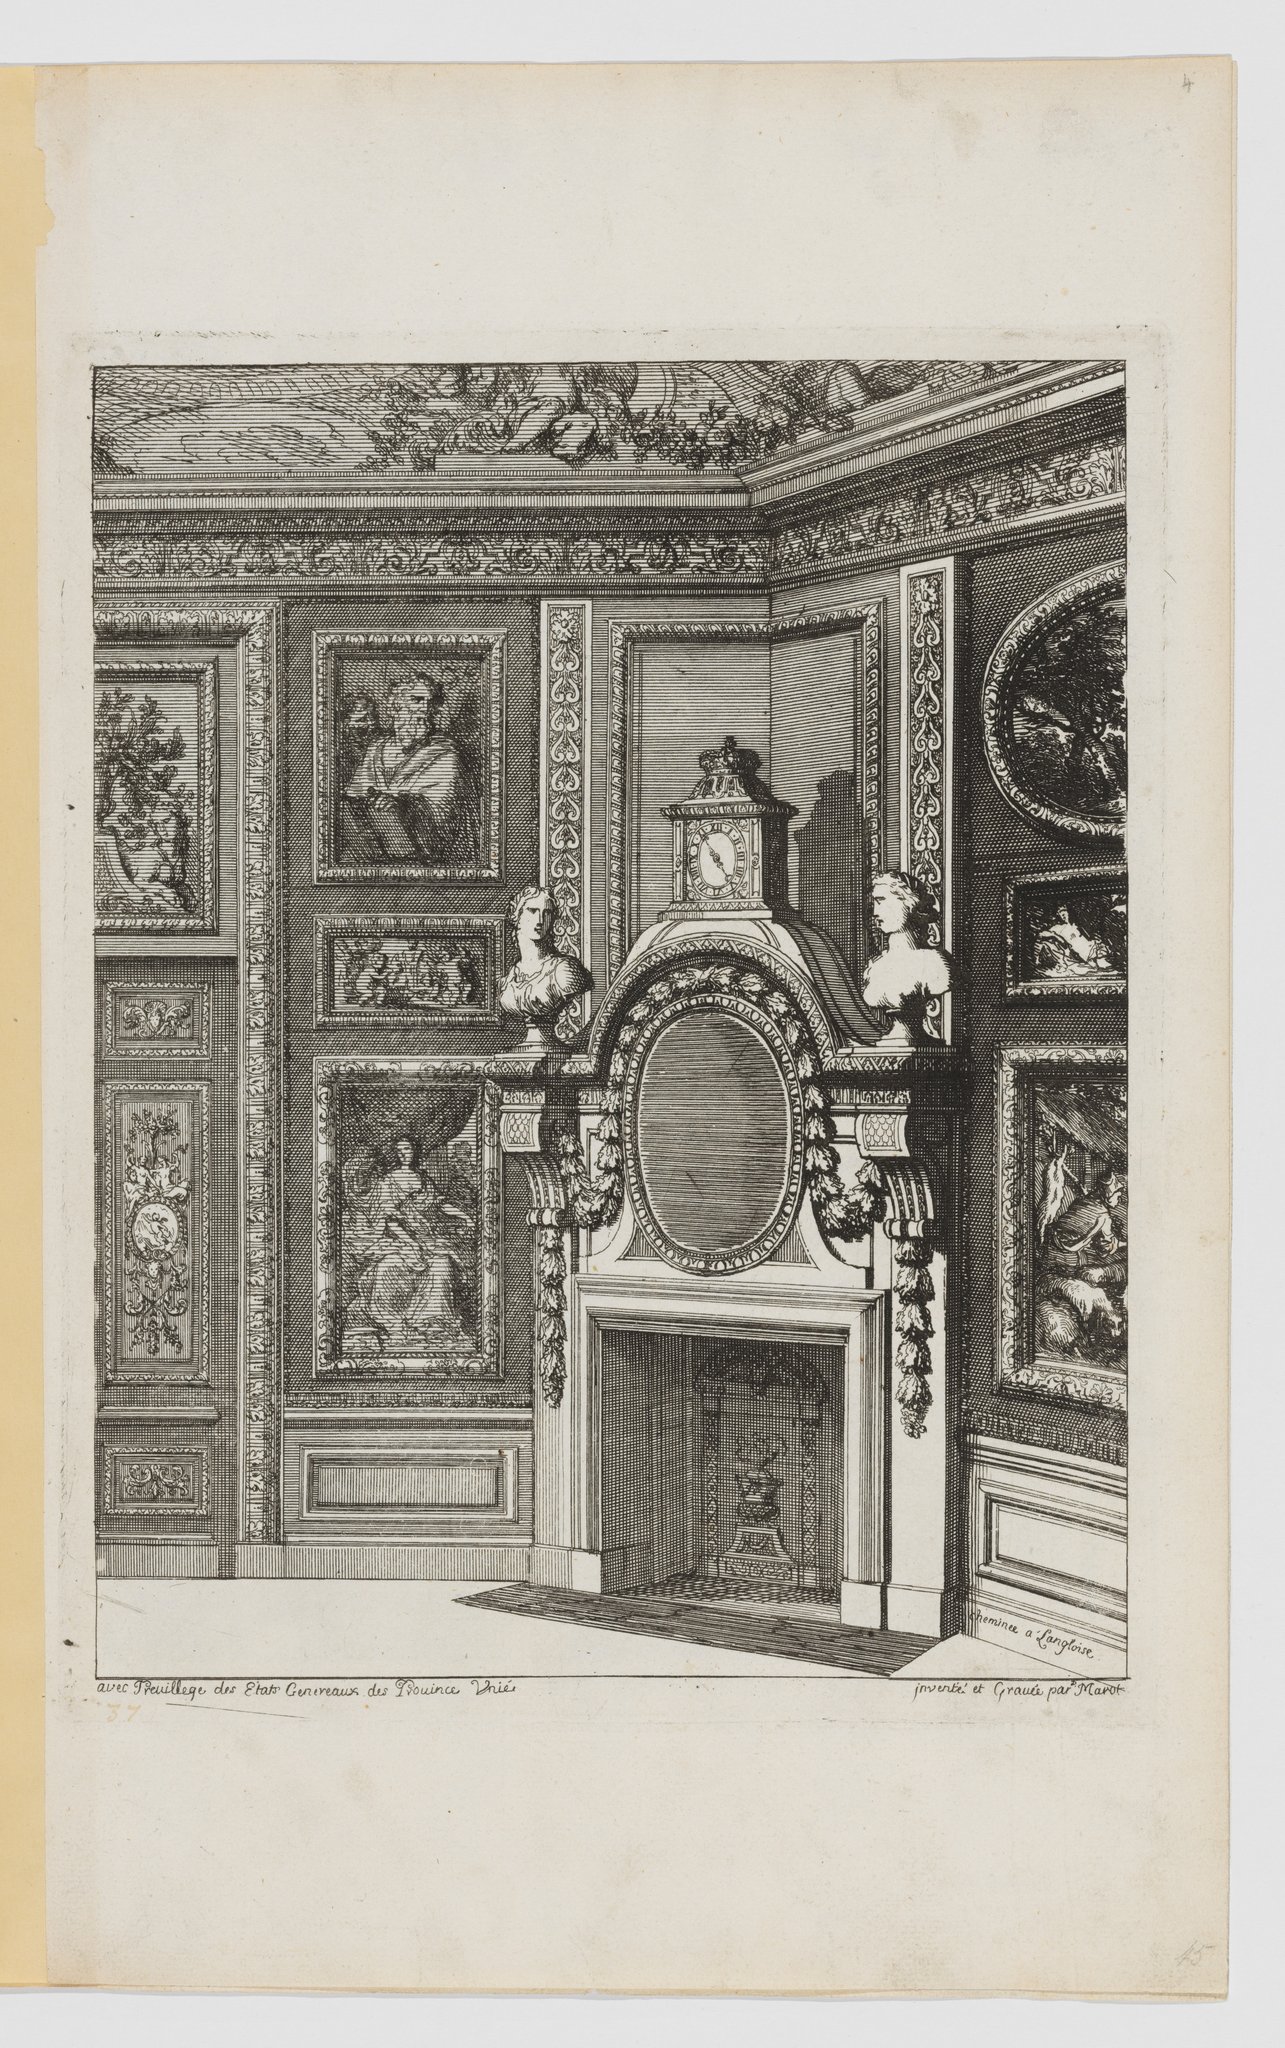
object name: print collection ornament architecture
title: Chimney-Piece Set in the Corner of a Room, from Nouvelles Cheminées Faittes en Plusieur en Droits de la Hollande et Autres Prouinces, part of Œuvres du Sr. D. Marot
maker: daniel marot the elder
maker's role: artist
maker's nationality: french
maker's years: 1661-1752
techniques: etching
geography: netherlands